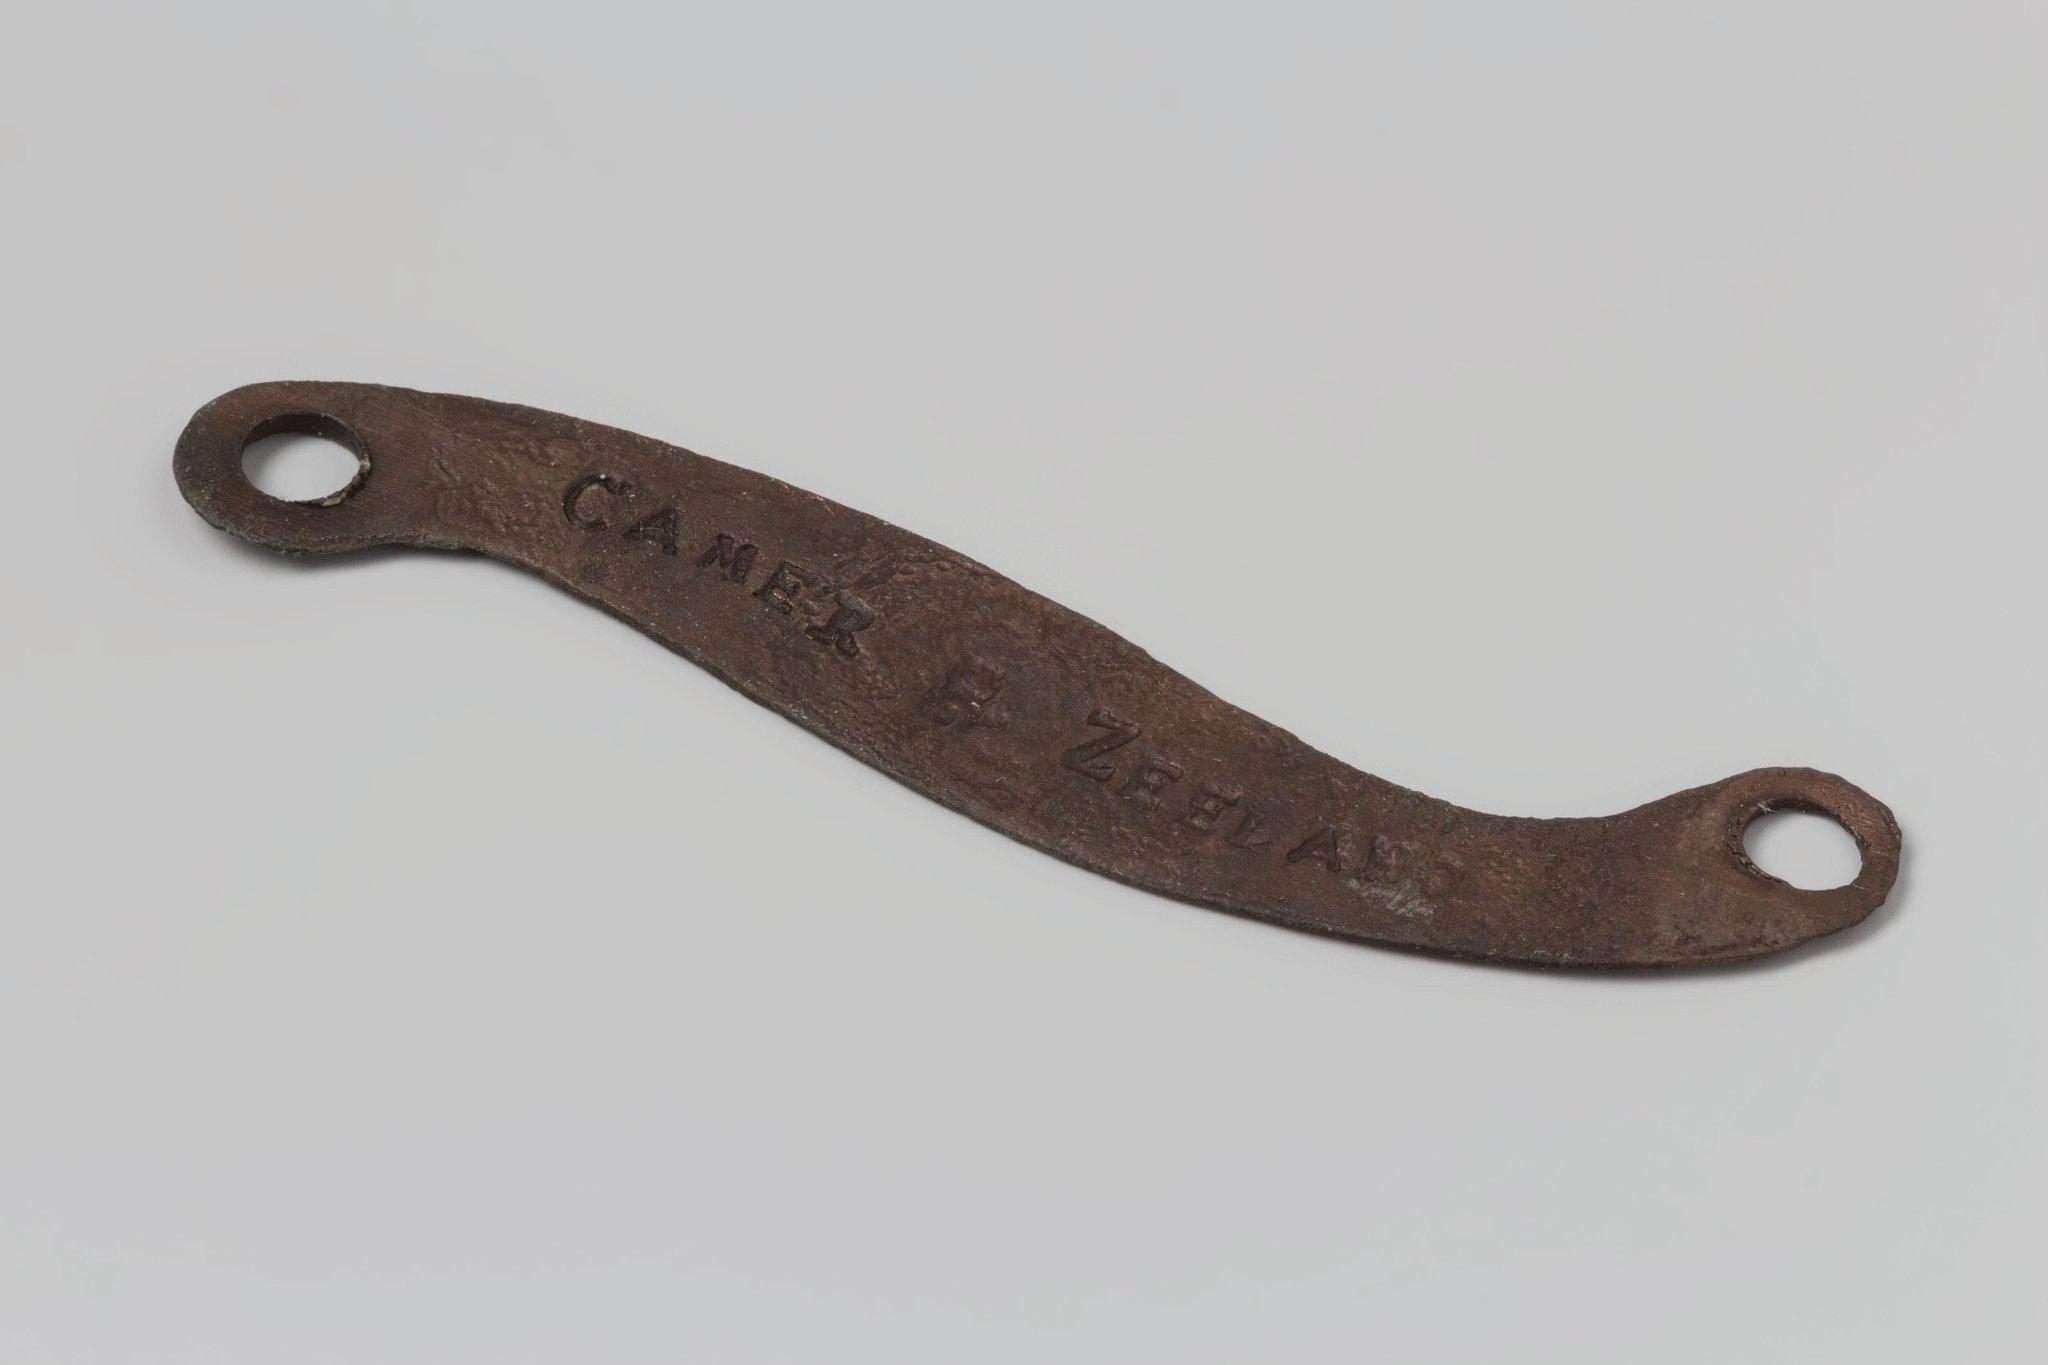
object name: schroefplaat, schroefblik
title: Side plate of a musket or pistol with reference to the East India chamber Zeeland from the wreck of the Dutch East Indiaman 't Vliegend Hart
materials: copper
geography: middelburg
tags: 't vliegend hart (schip), verenigde oostindische compagnie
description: Koperen schroefplaat van een musket met het opschrift 'camer zeeland'. Side plate.